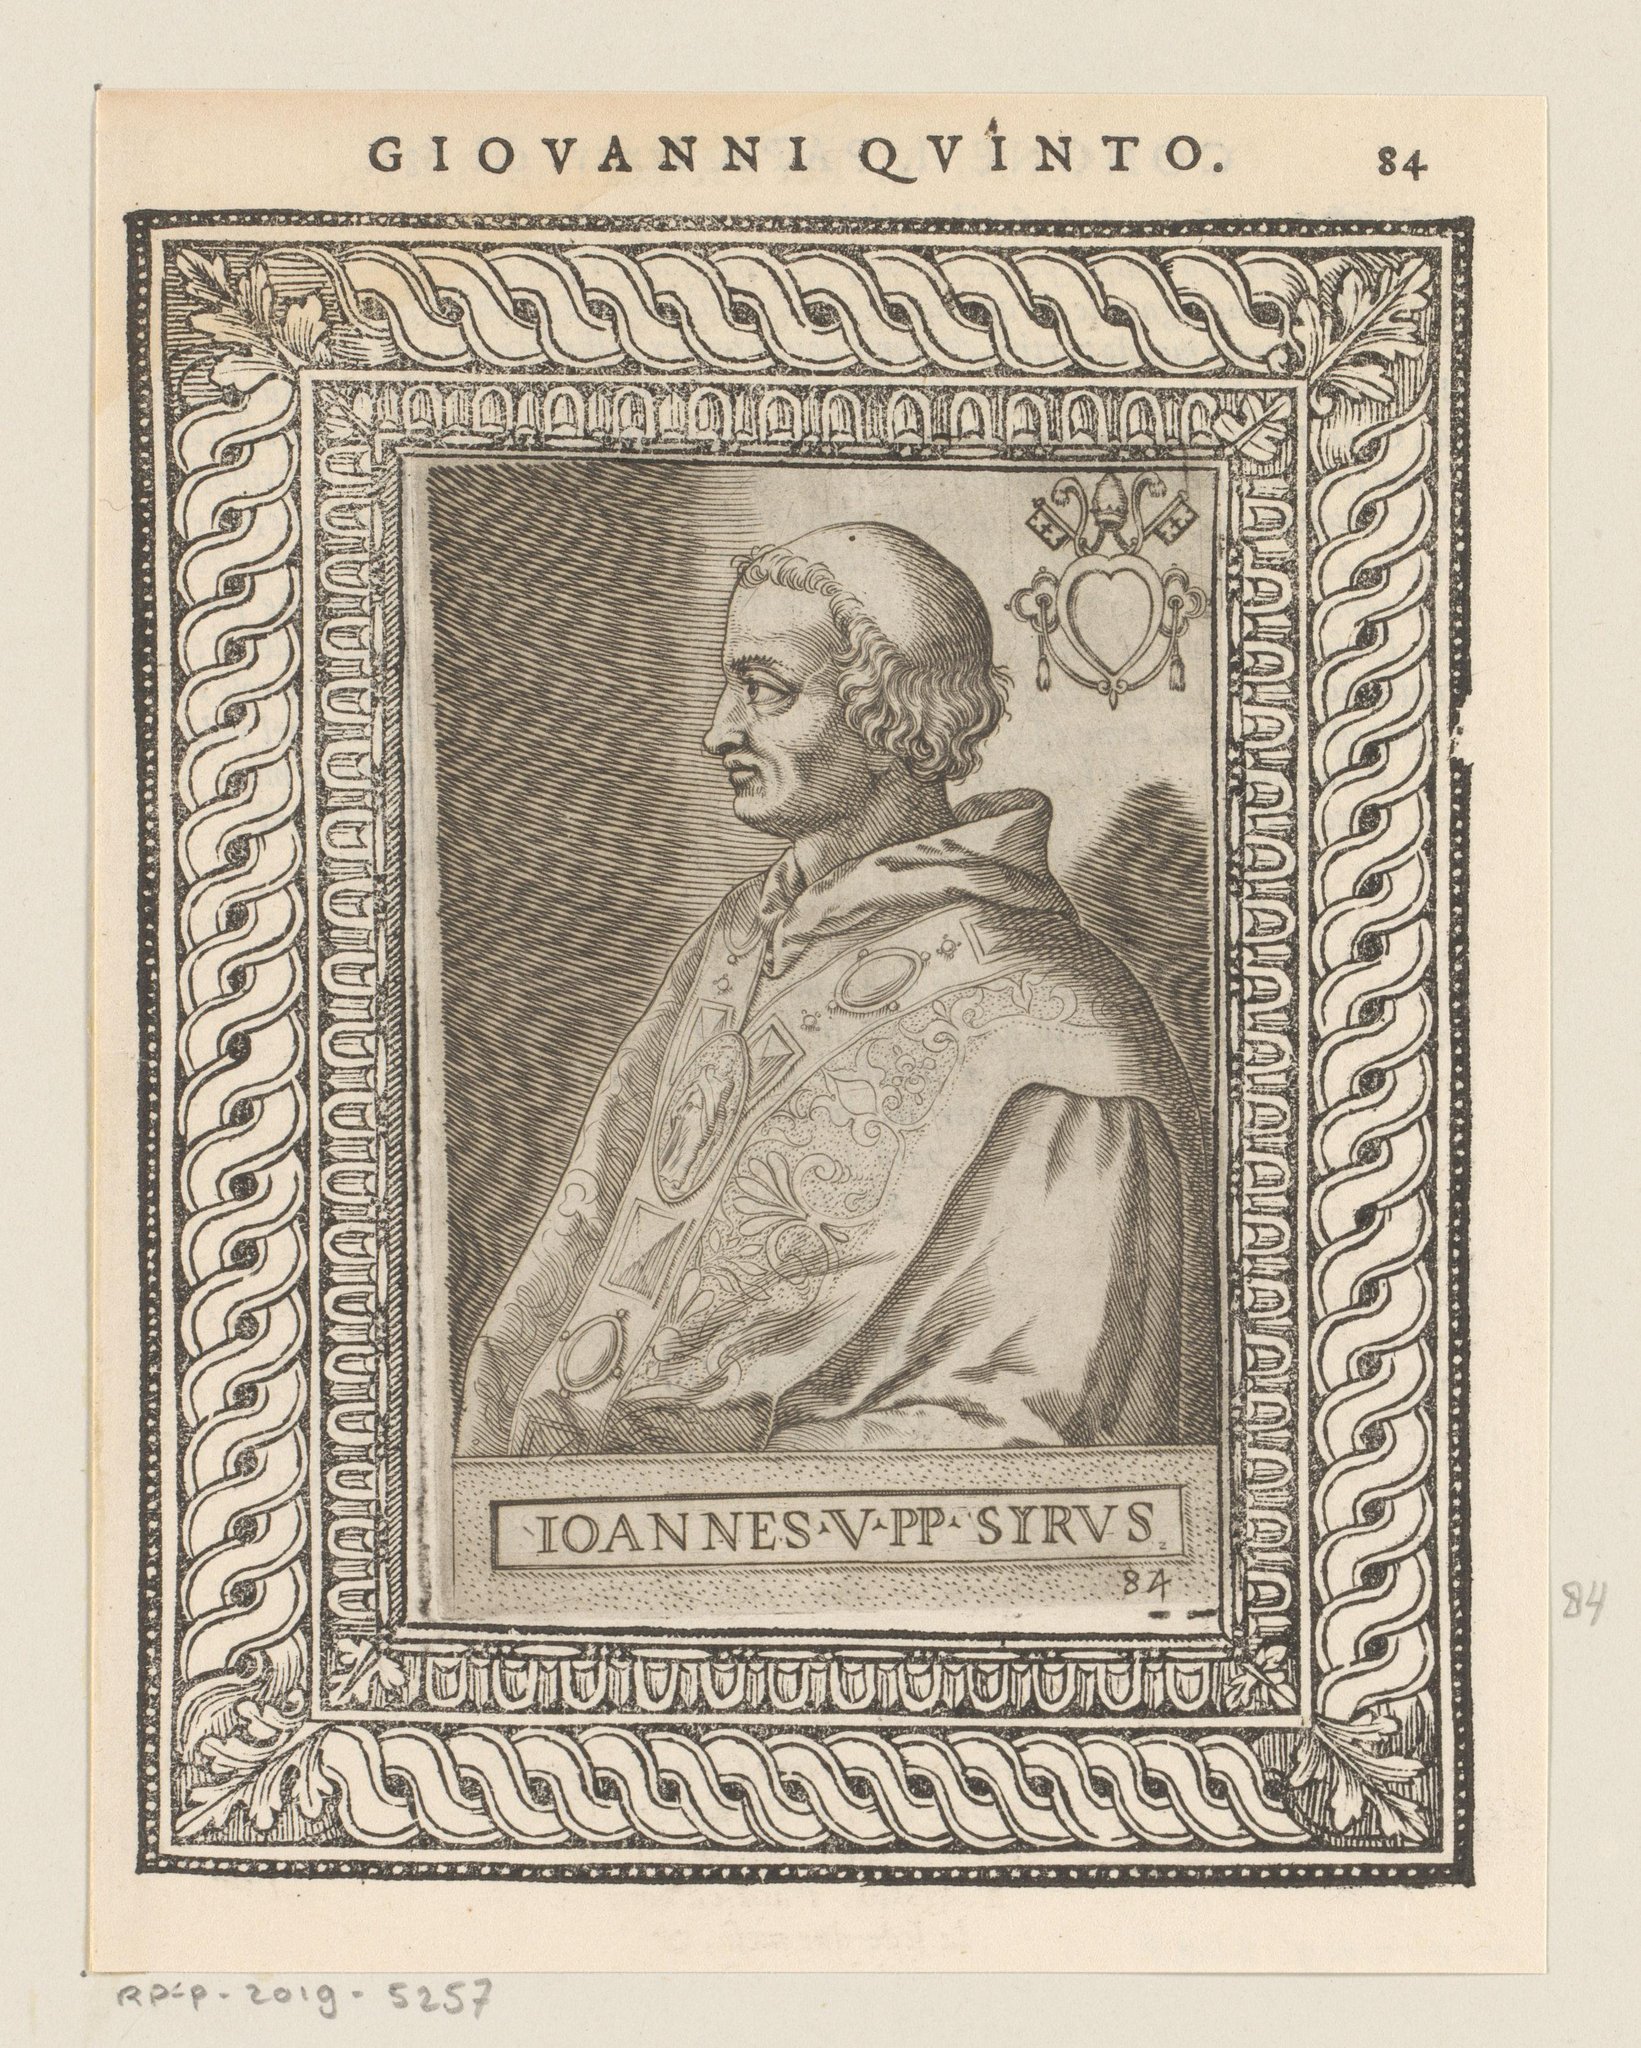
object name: print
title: Portret van paus Johannes V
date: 1587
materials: paper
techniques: engraving, letterpress printing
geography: rome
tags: historical persons, pope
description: Prent uit: Ciccarelli, Antonio. Le vite de Pontefici di Antonio Ciccarelli (...). Rome: Domenico Basa, 1587. Prent voor het eerst verschenen in: Cavalieri, Giovanni Battista de'. Pontificum romanorum effigies (...). Rome: Domenico Basa en Francesco Zanetti, 1580. Prent ook gebruikt in latere publicaties.